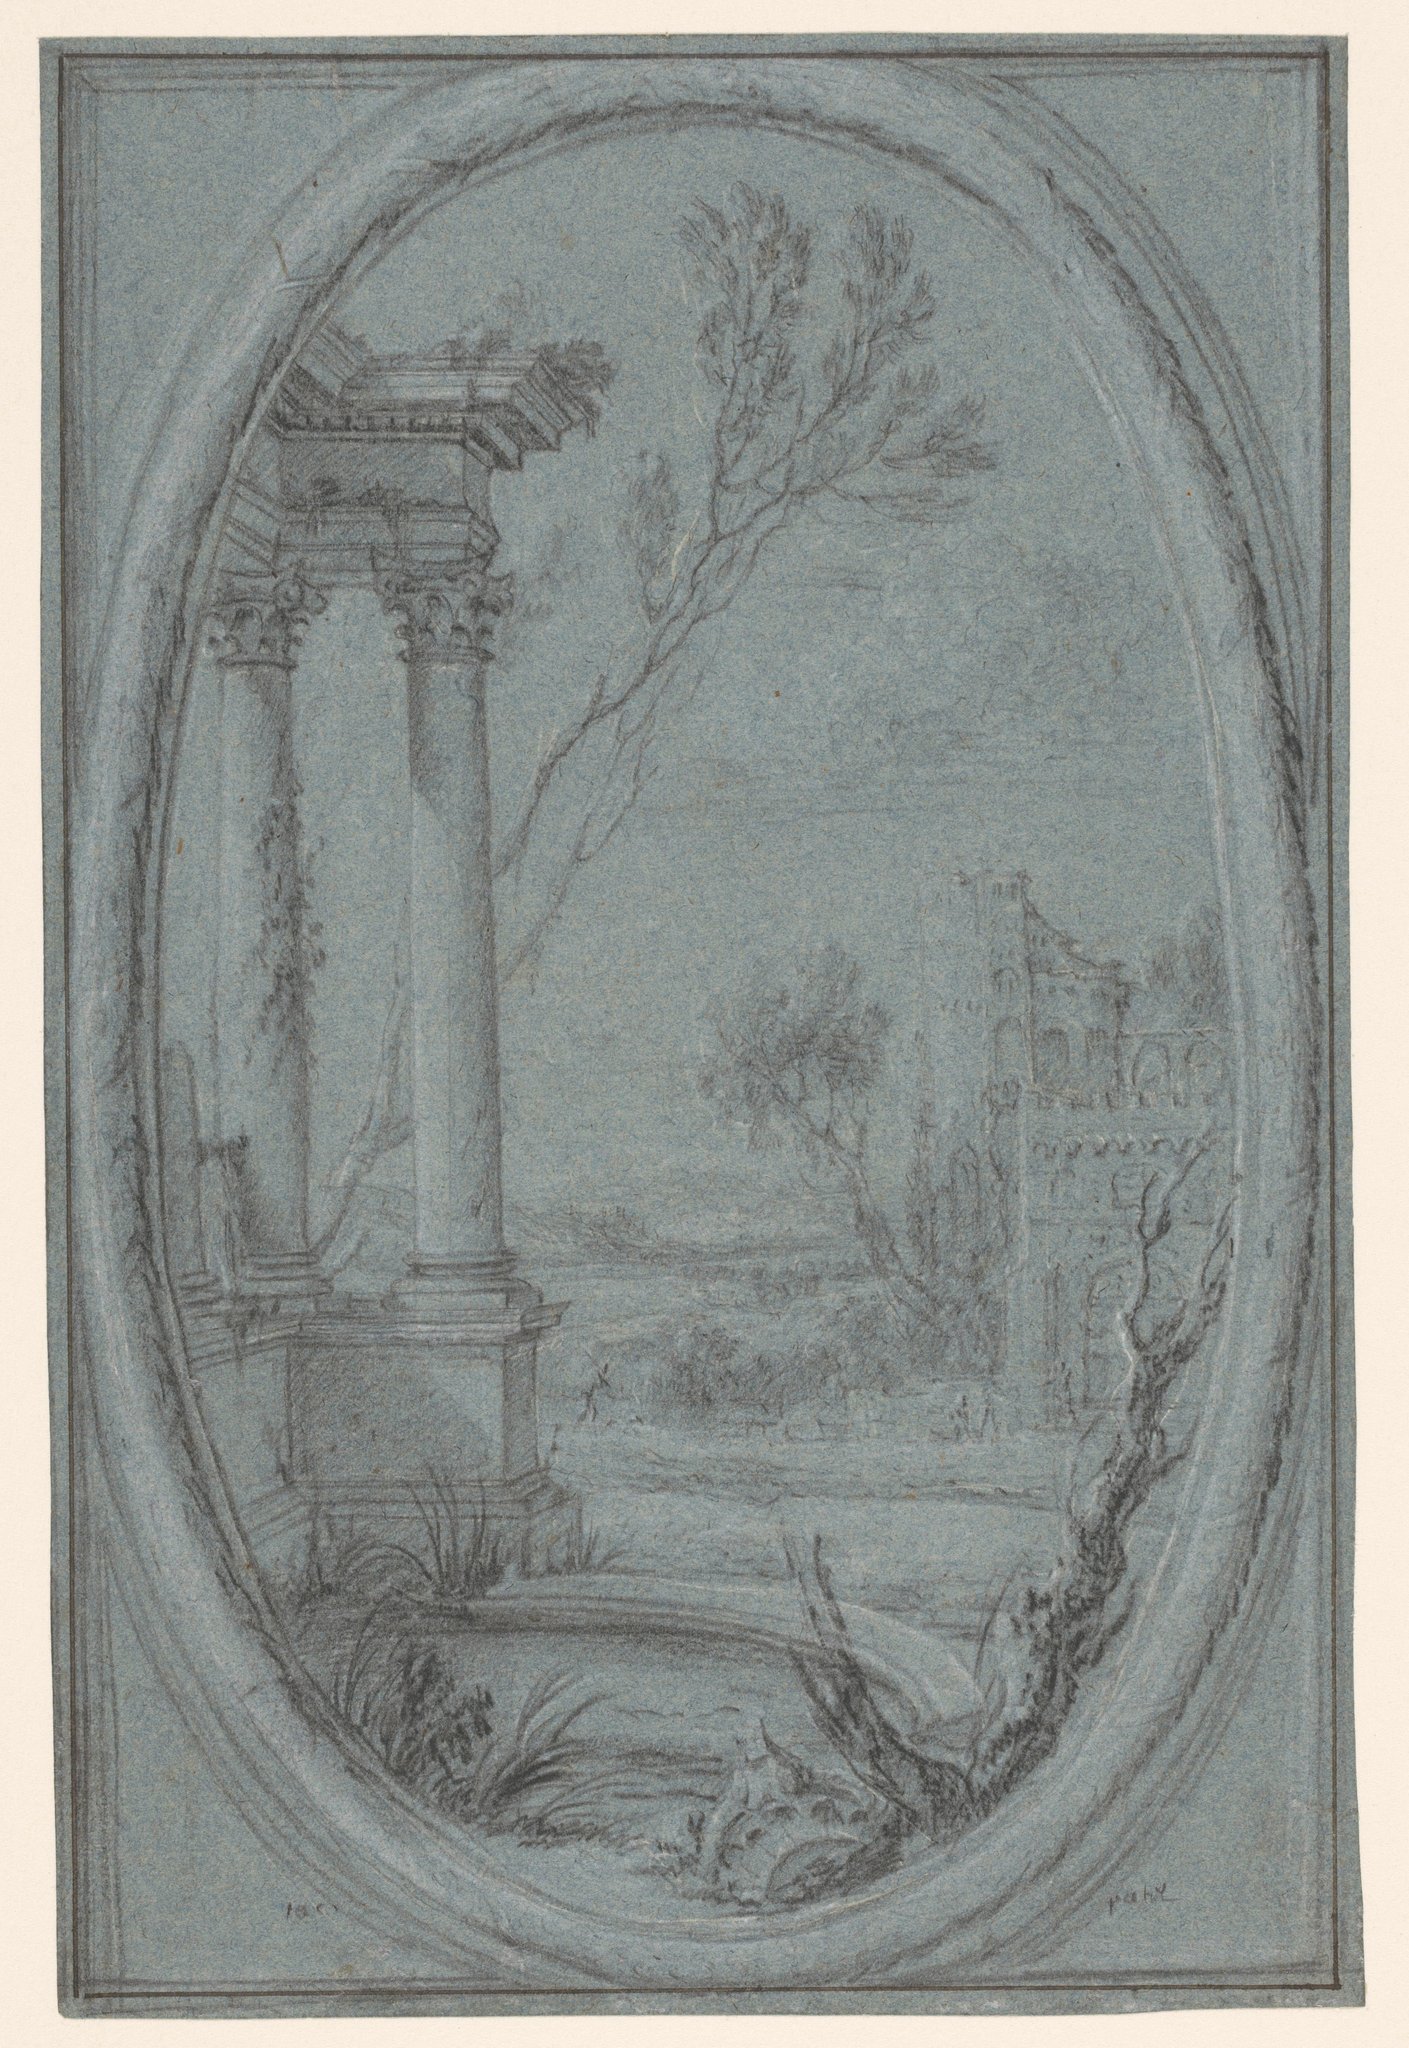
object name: drawing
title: Landschap met tempelruïne in ovale lijst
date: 1640-1662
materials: chalk, paper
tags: landscape with ruins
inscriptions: signature: ‘Patel’